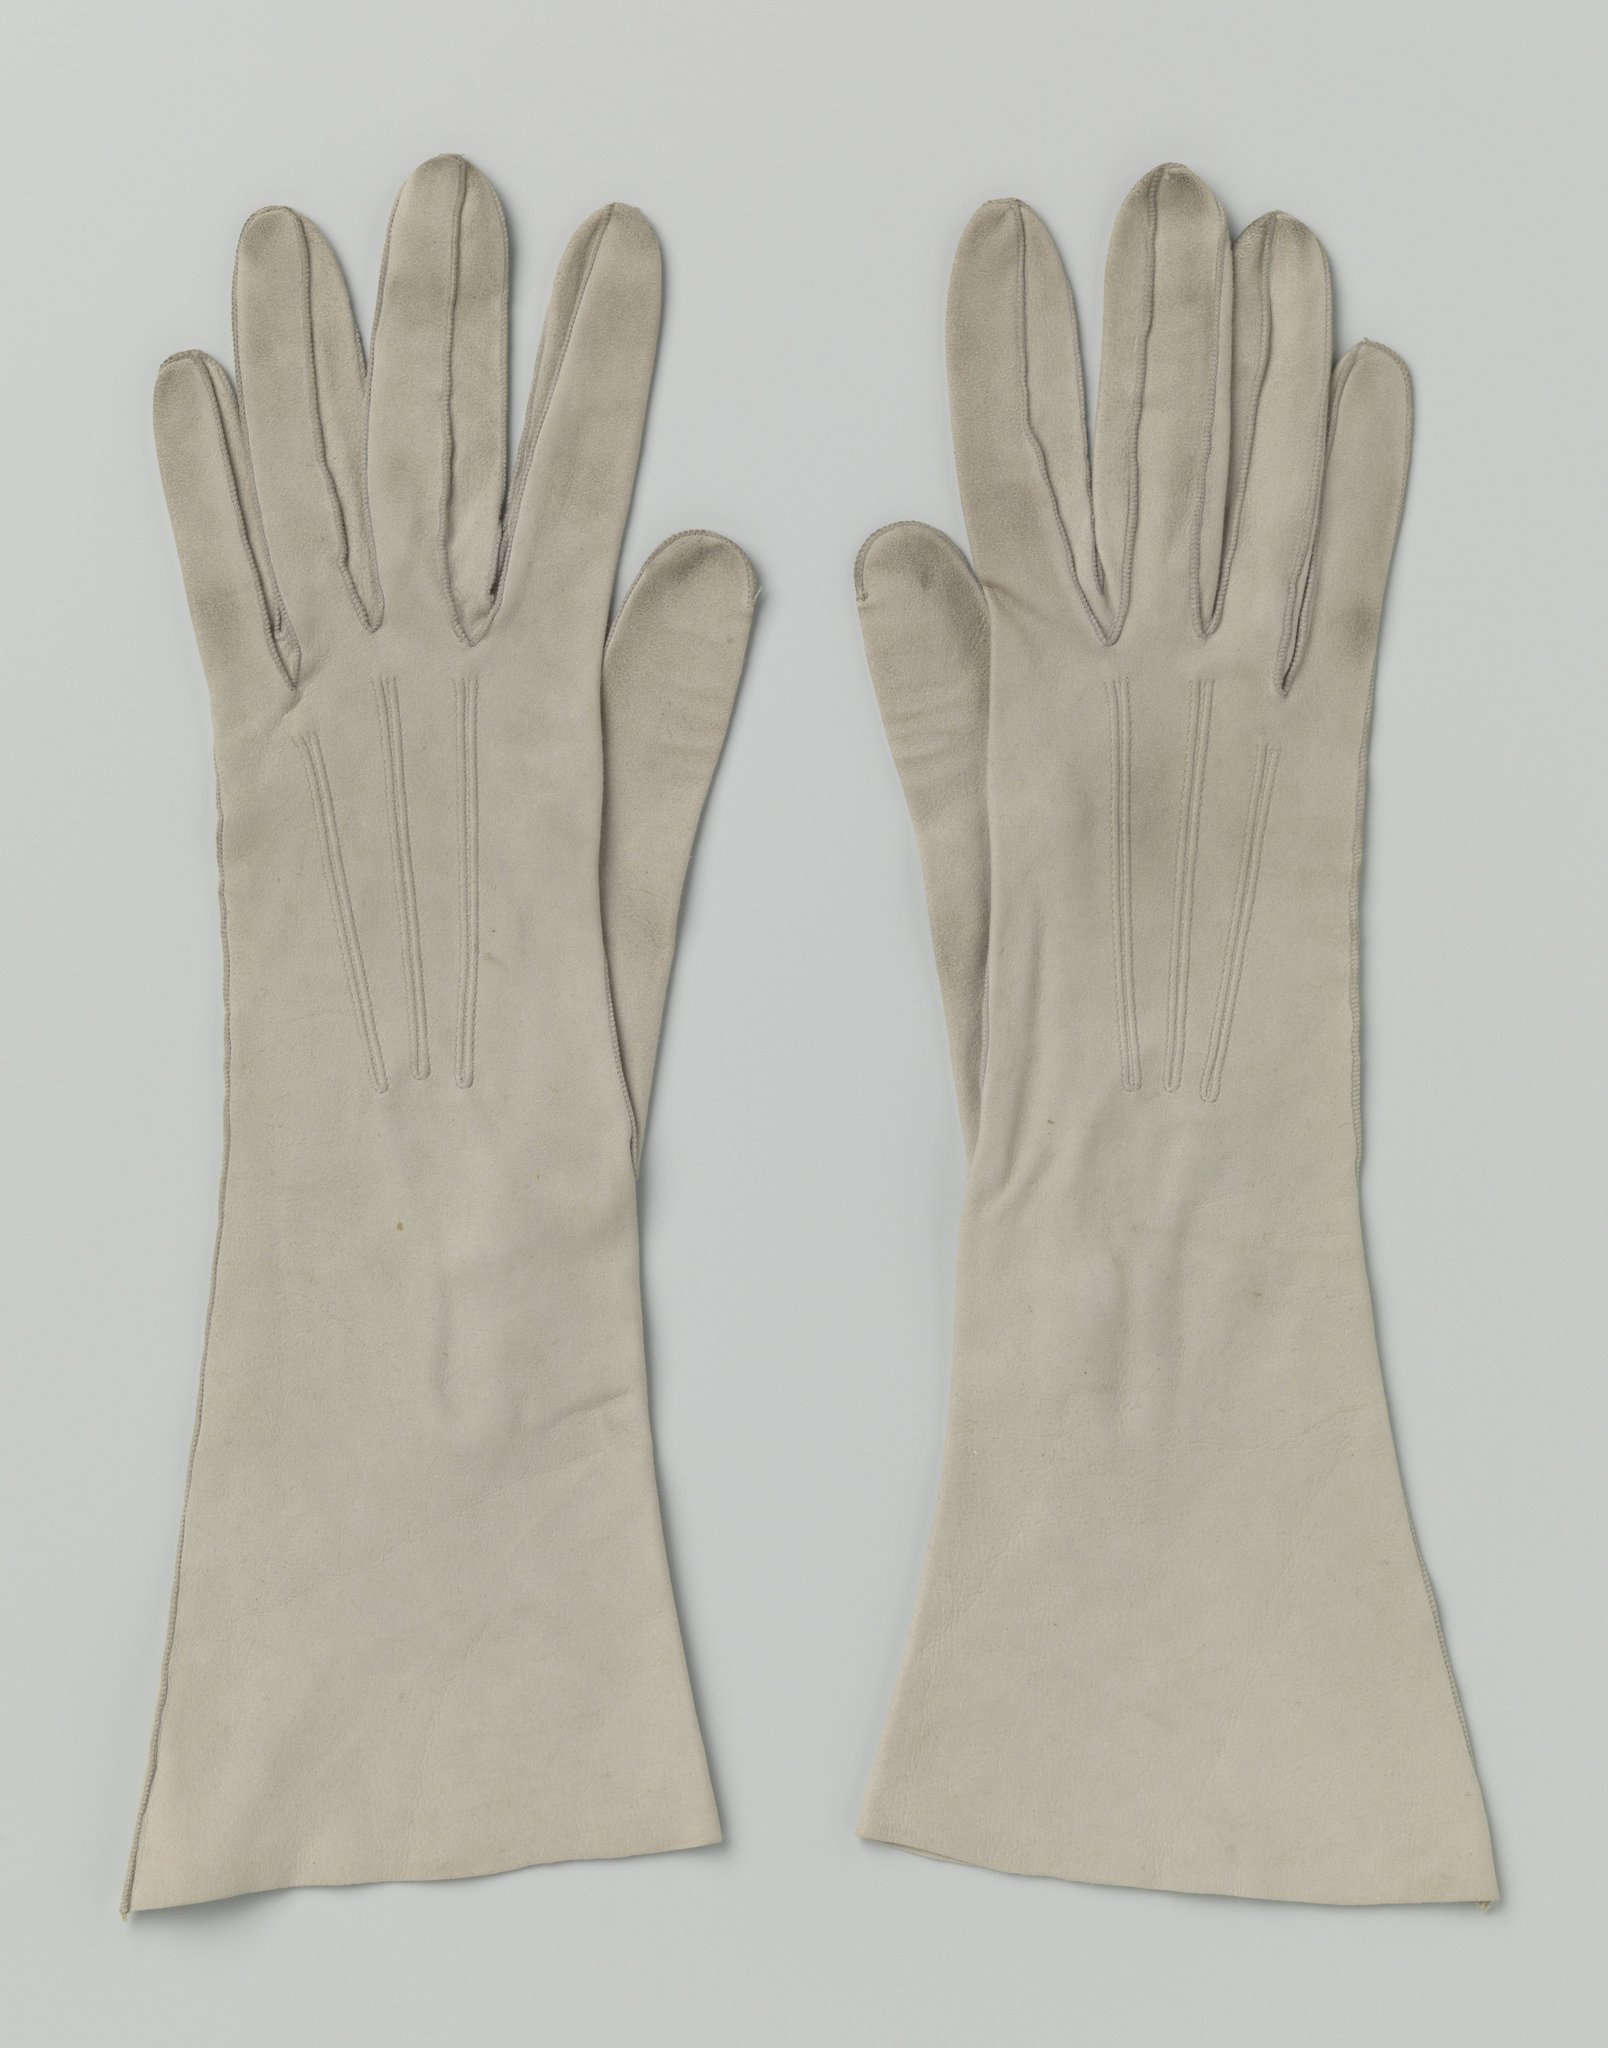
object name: glove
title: Handschoen van grijs wasleer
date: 1900-1950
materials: leather, plastic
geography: netherlands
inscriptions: stamp: ‘tekst’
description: Linker handschoenen van grijs wasleer met aangeknipte kap. Op de rug drie gestikte lijnen. Bij de pols en split met knoopsluiting en parelmoerkleurige kunsstof knoop.